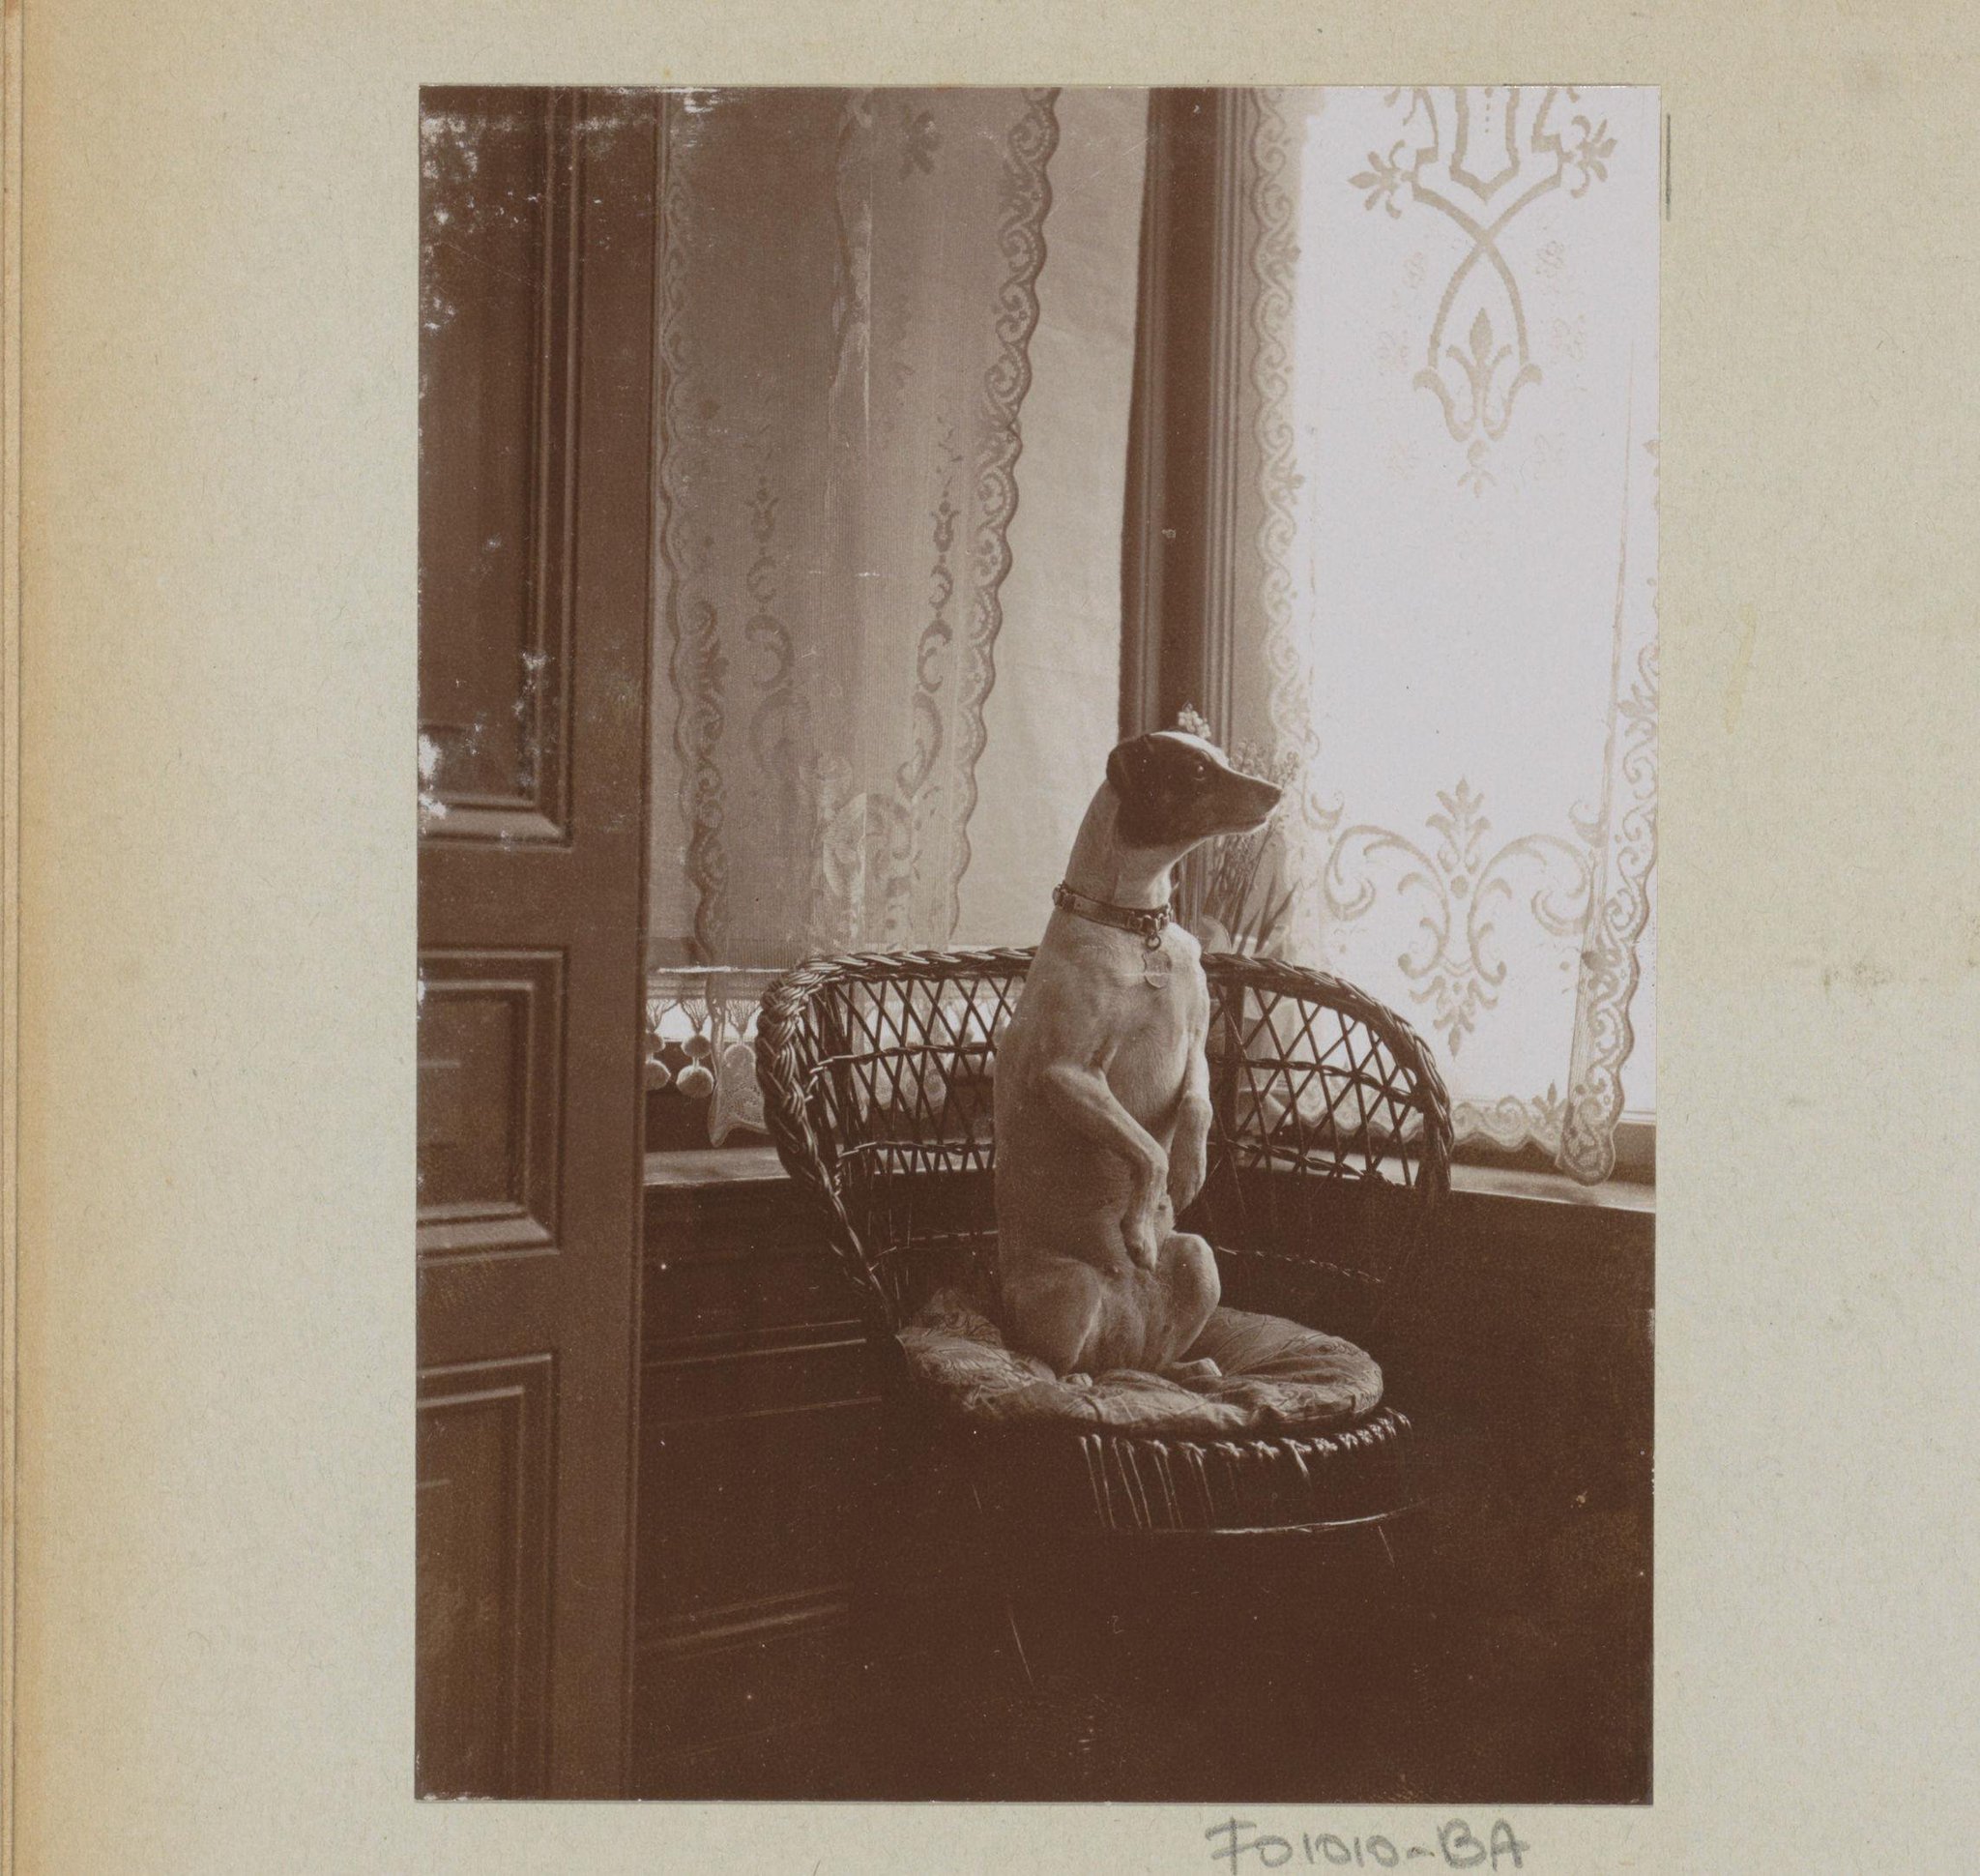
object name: photograph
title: Opzittende hond in een stoel bij een raam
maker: Anonymous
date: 1900-1910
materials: photographic support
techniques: collodion silver print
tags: training of performing dog, chair, dog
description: Onderdeel van Familiealbum met onder meer foto's van Wijnhandel Kraaij & Co. Bordeaux-Amsterdam.